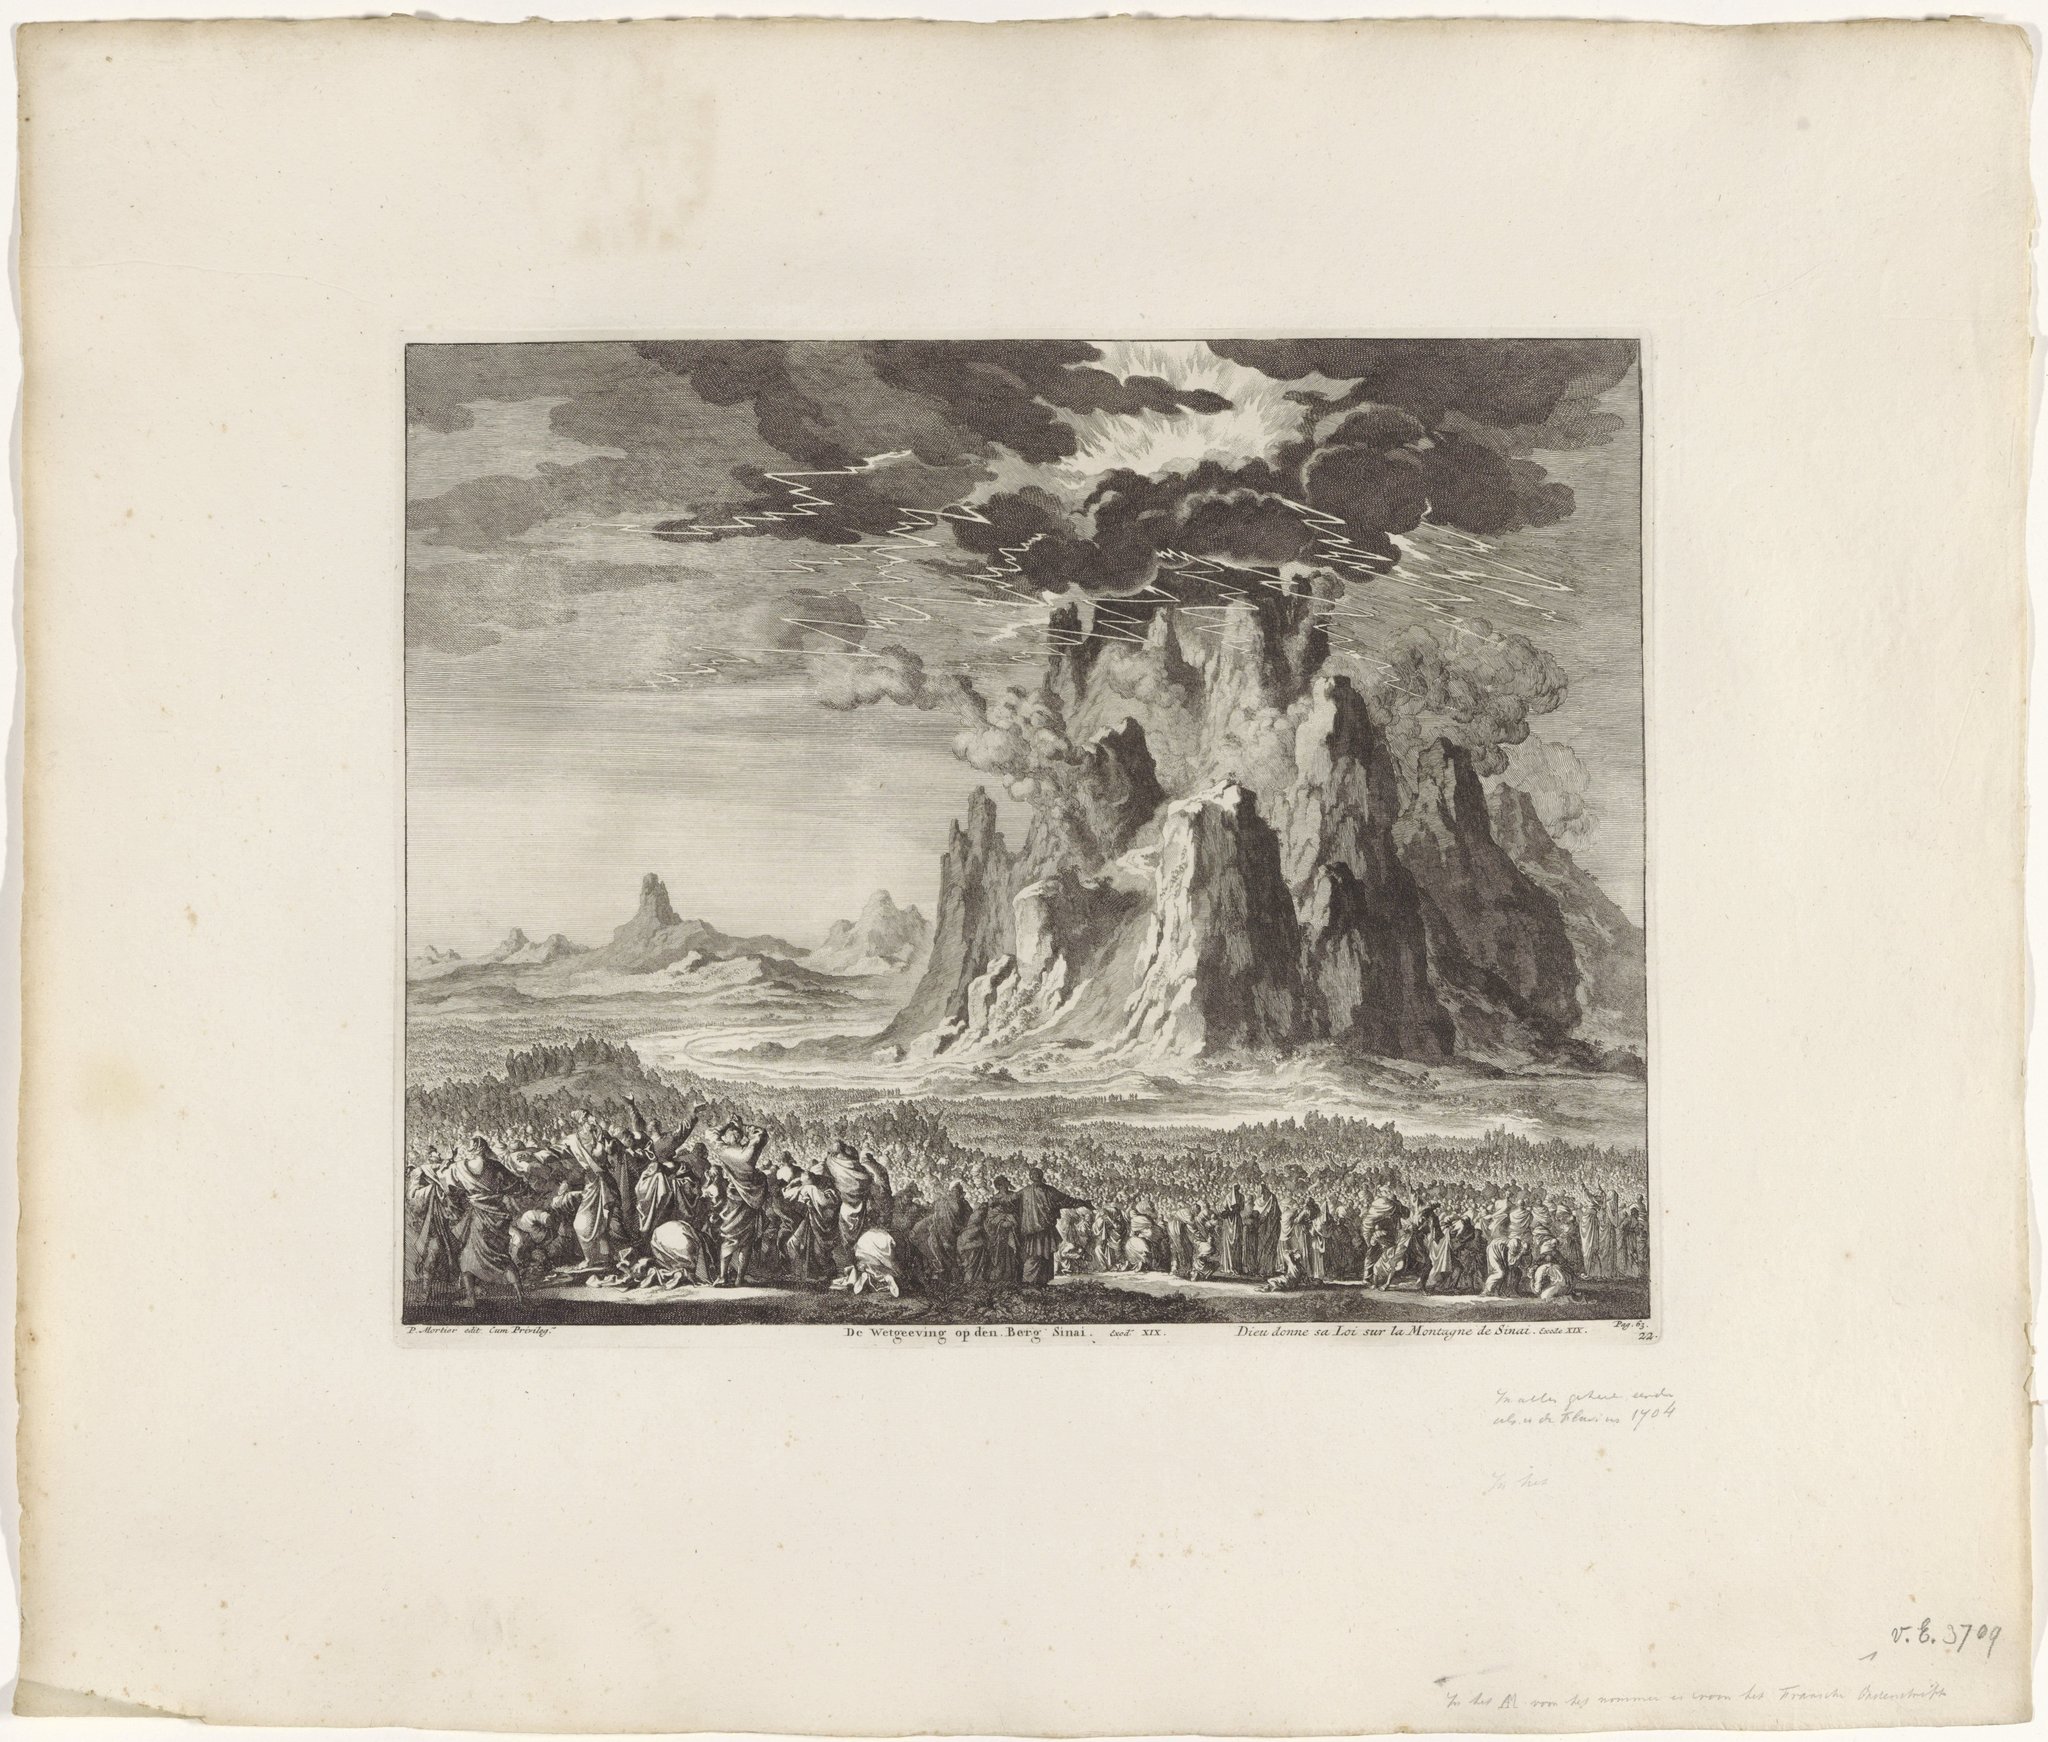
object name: book illustration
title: Wetgeving op de berg Sinaï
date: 1708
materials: paper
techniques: etching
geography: amsterdam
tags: mount sinai is covered by a thick cloud, thunder and lightning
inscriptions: collector's mark: Lugt 2228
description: Mozes spreekt met God op de berg Sinaï. Het Joodse volk op de voorgrond raakt in paniek bij het horen van donderslagen en het zien van lichtflitsen en van rook die uit de berg komt (Ex. 20:21).